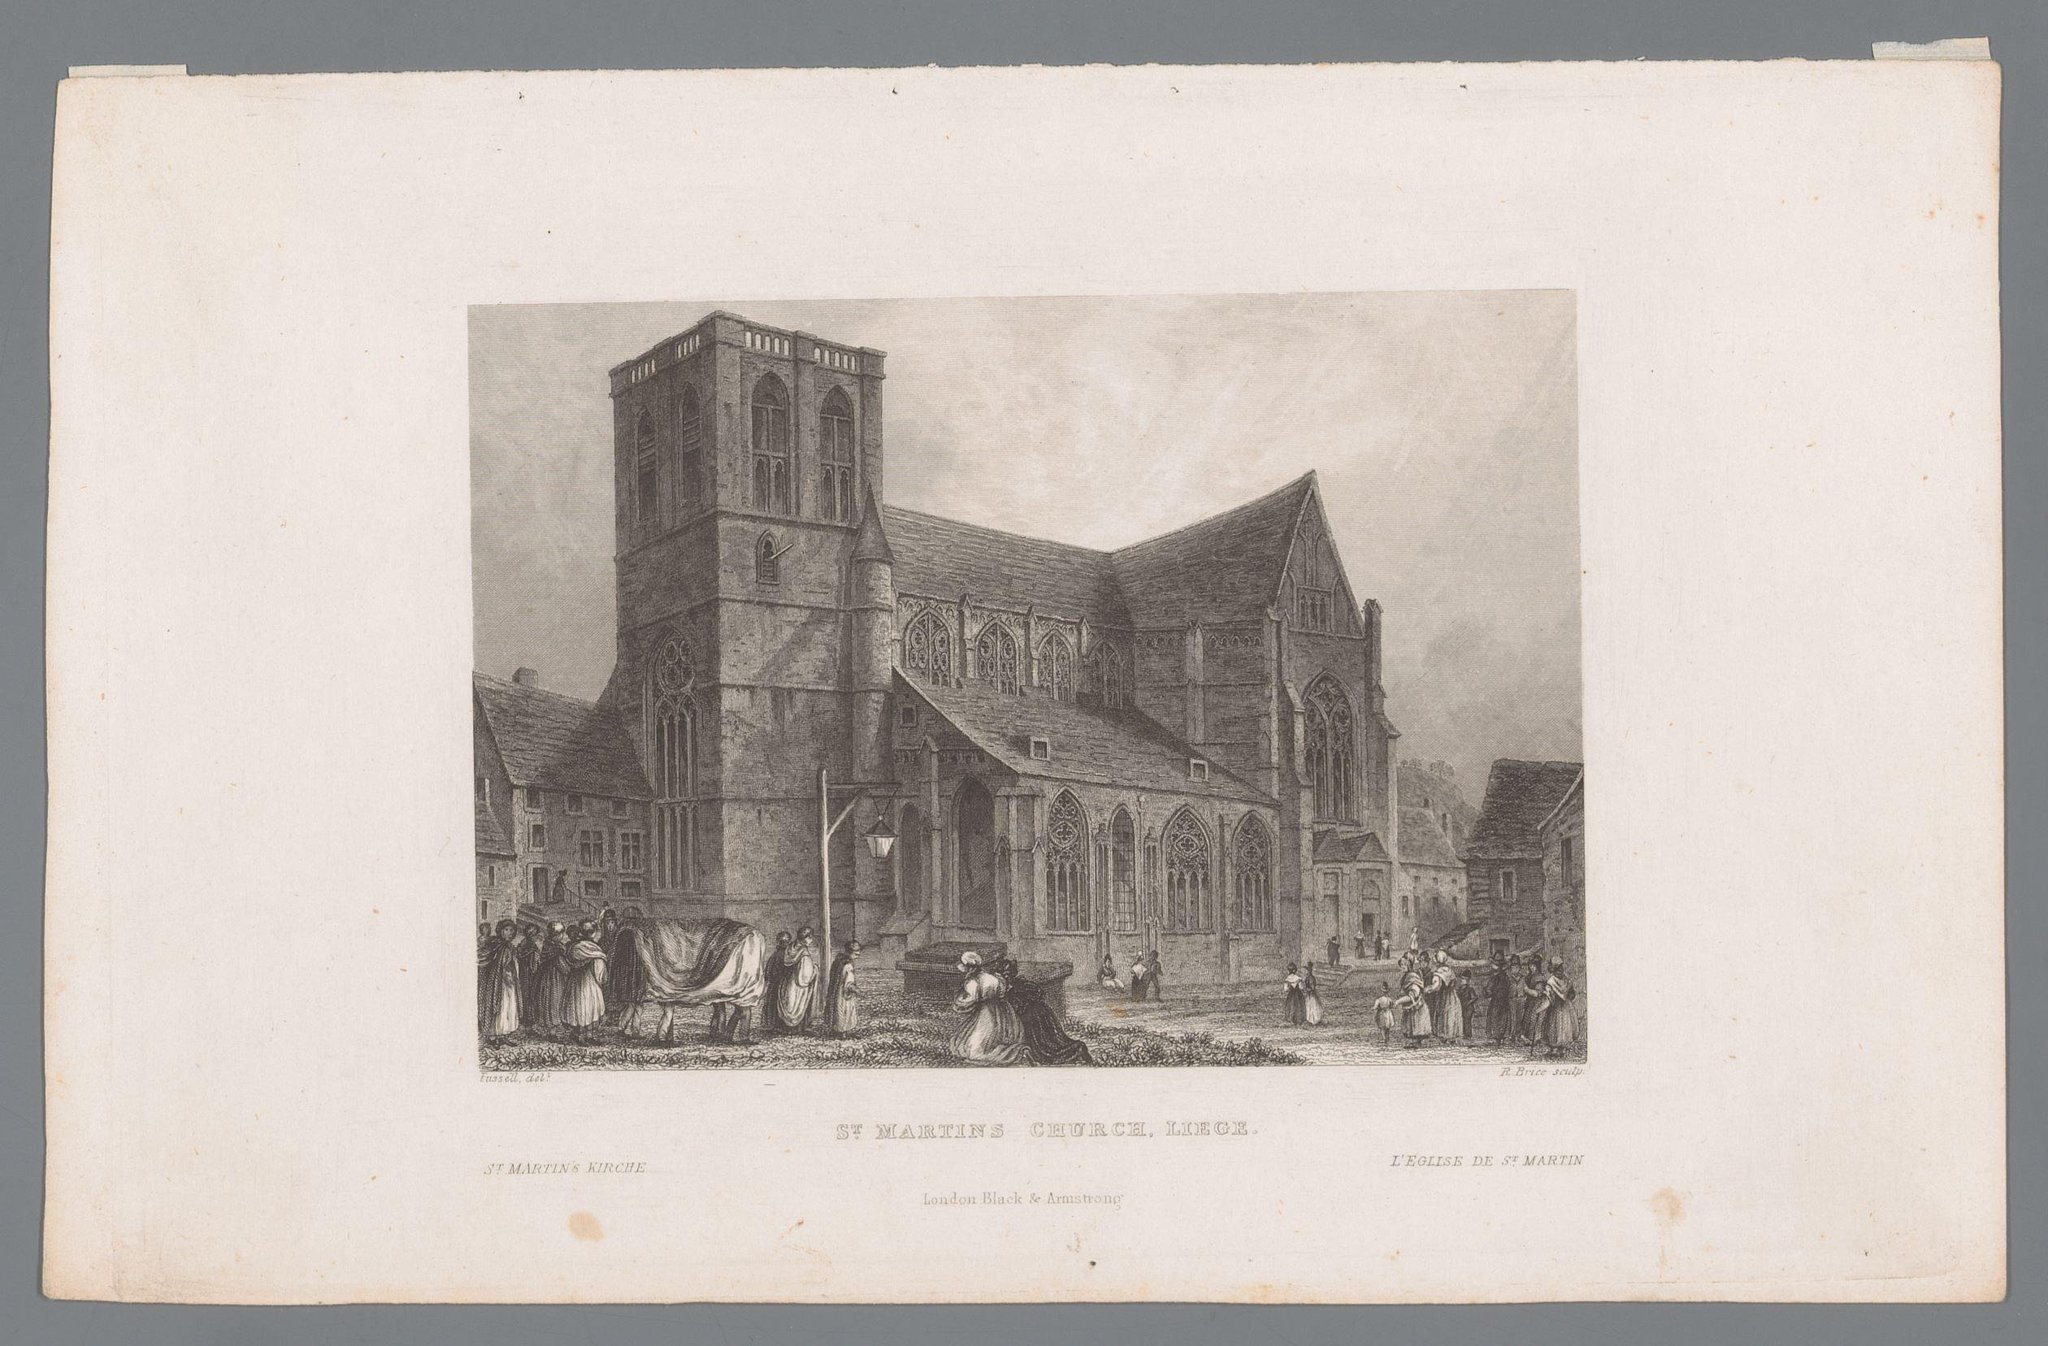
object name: book illustration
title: Gezicht op de Sint-Maartensbasiliek in Luik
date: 1850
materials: paper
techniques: engraving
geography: london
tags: church (exterior), liège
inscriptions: collector's mark: Lugt 2233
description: Prent uit: The Continental Tourist, and Pictorial Companion. Tweede druk. London: Black & Armstrong, [ca. 1850].